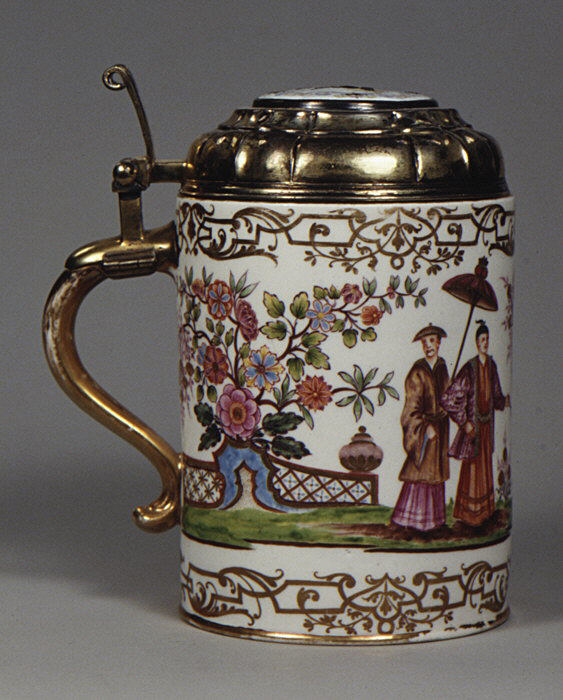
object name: tankard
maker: meissen manufactory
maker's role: manufactory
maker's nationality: german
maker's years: 1710-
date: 1737-1744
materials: hard paste porcelain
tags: men,flowers